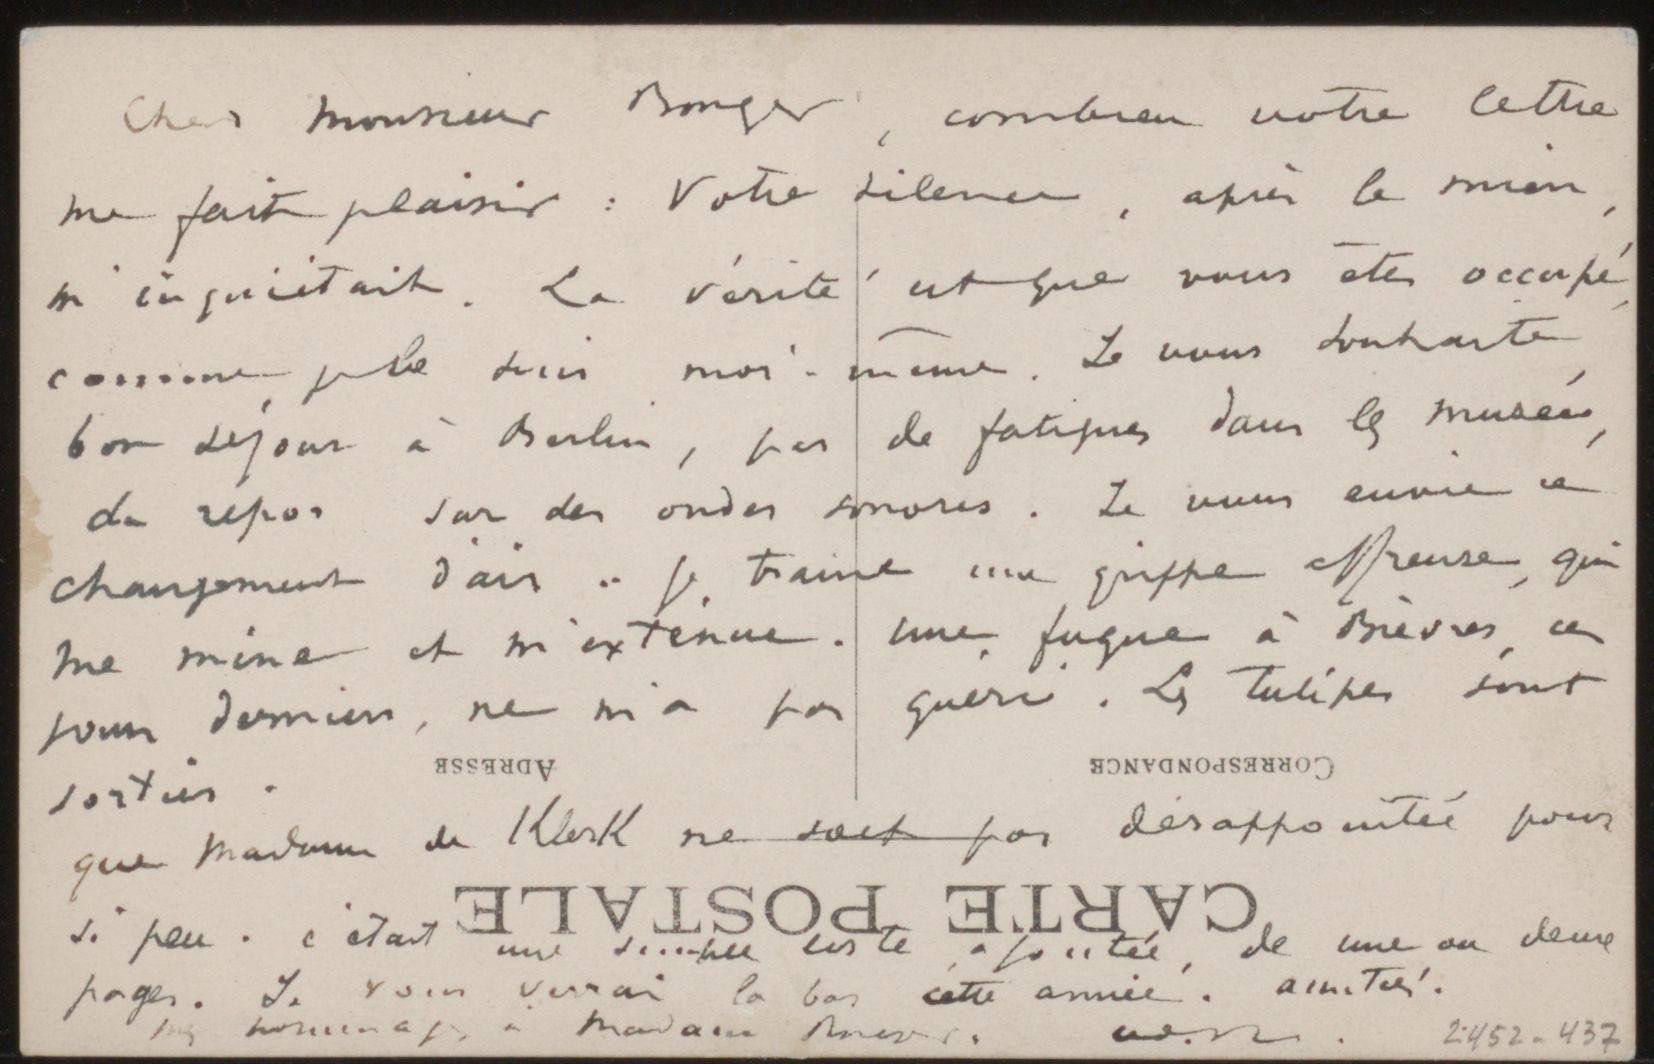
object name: ansichtkaart, prentbriefkaart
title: Prentbriefkaart aan Andries Bonger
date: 1912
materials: cardboard, ink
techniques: pen, printing, writing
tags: amsterdam, andries bonger, rotterdam, maria viola, berlin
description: Prentbriefkaart behoort tot een album samengesteld door weduwe Françoise W.M. Barones van der Borch van Verwolde met afschriften van brieven met betrekking tot (de familie van) Odilon Redon. De prentbriefkaart werd bewaard op pagina 185.